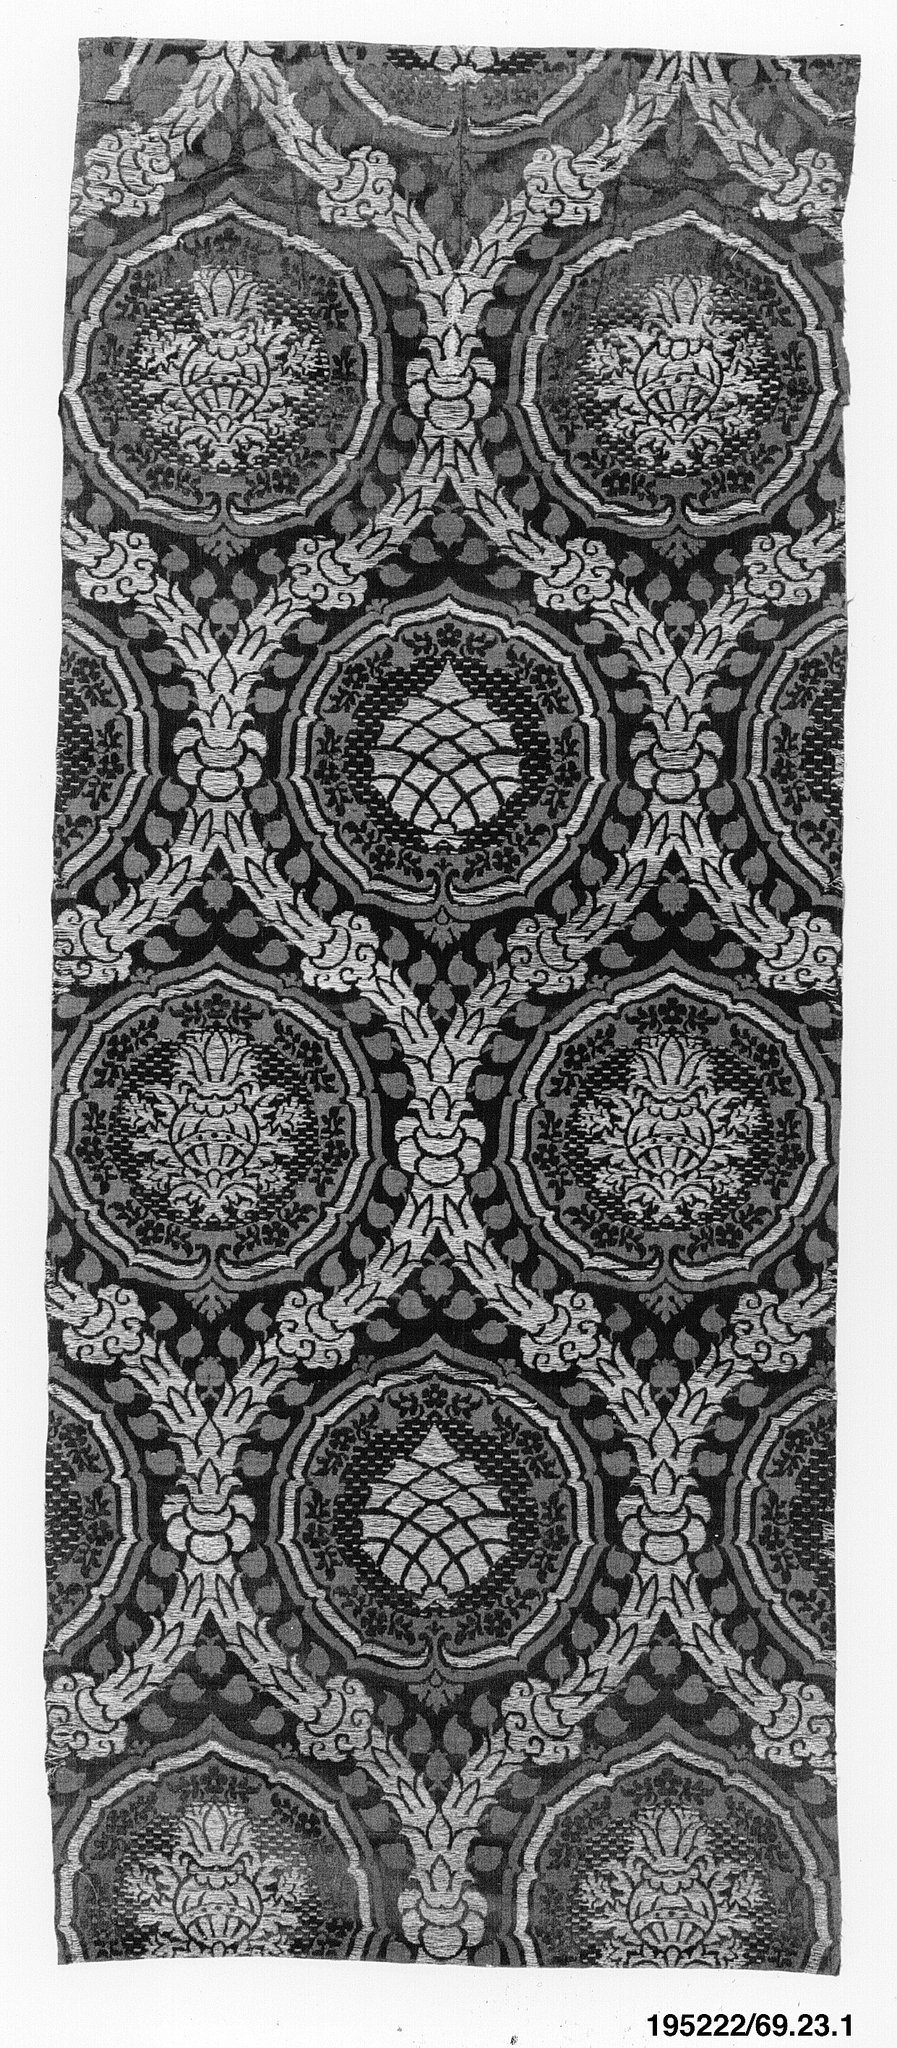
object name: piece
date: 1501-1600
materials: metal thread, silk